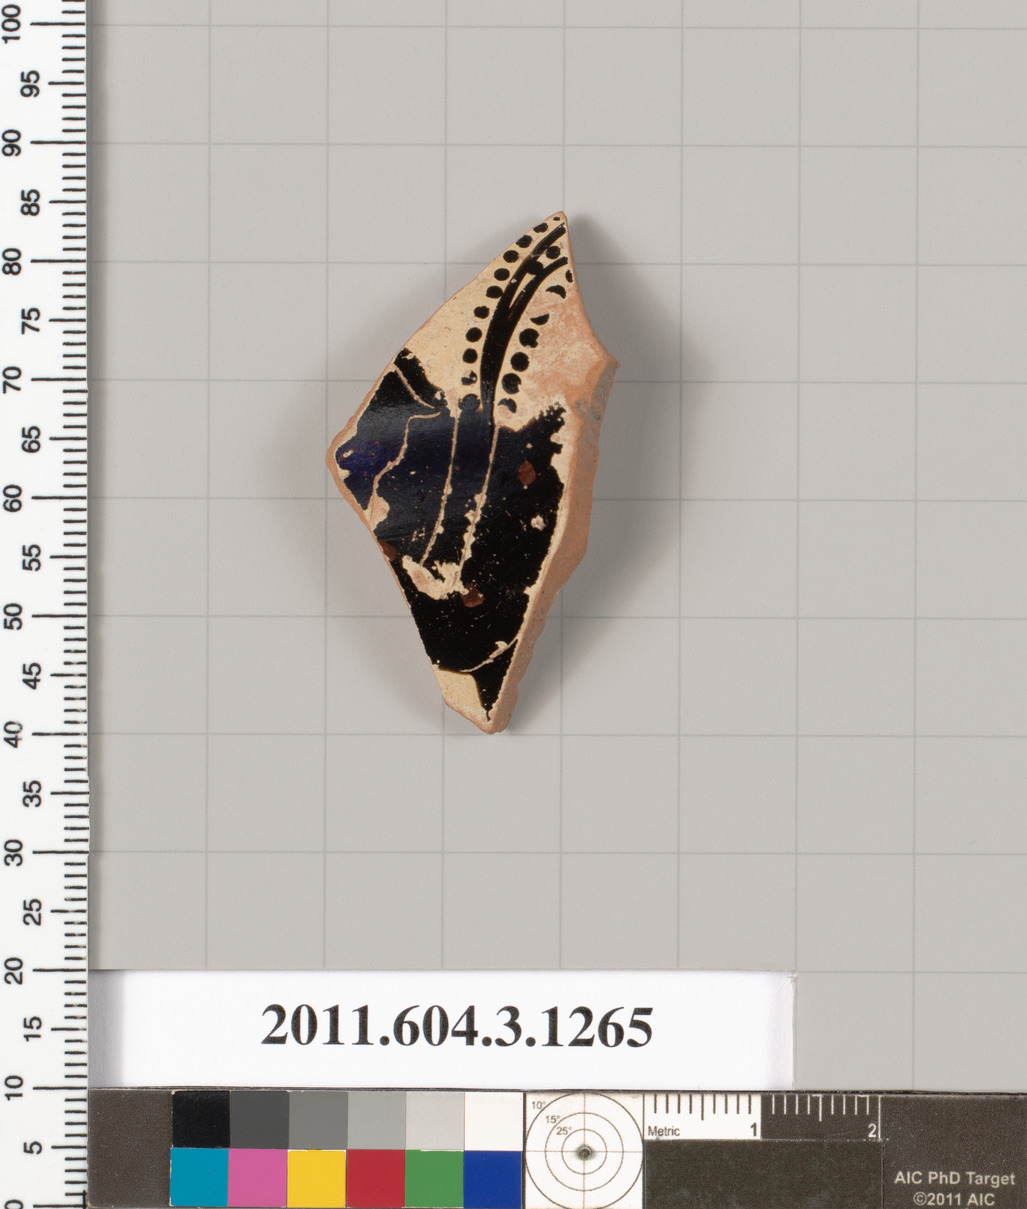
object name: oinochoe fragment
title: Terracotta fragment of an oinochoe (jug)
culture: greek, attic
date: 534-468 BCE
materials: terracotta